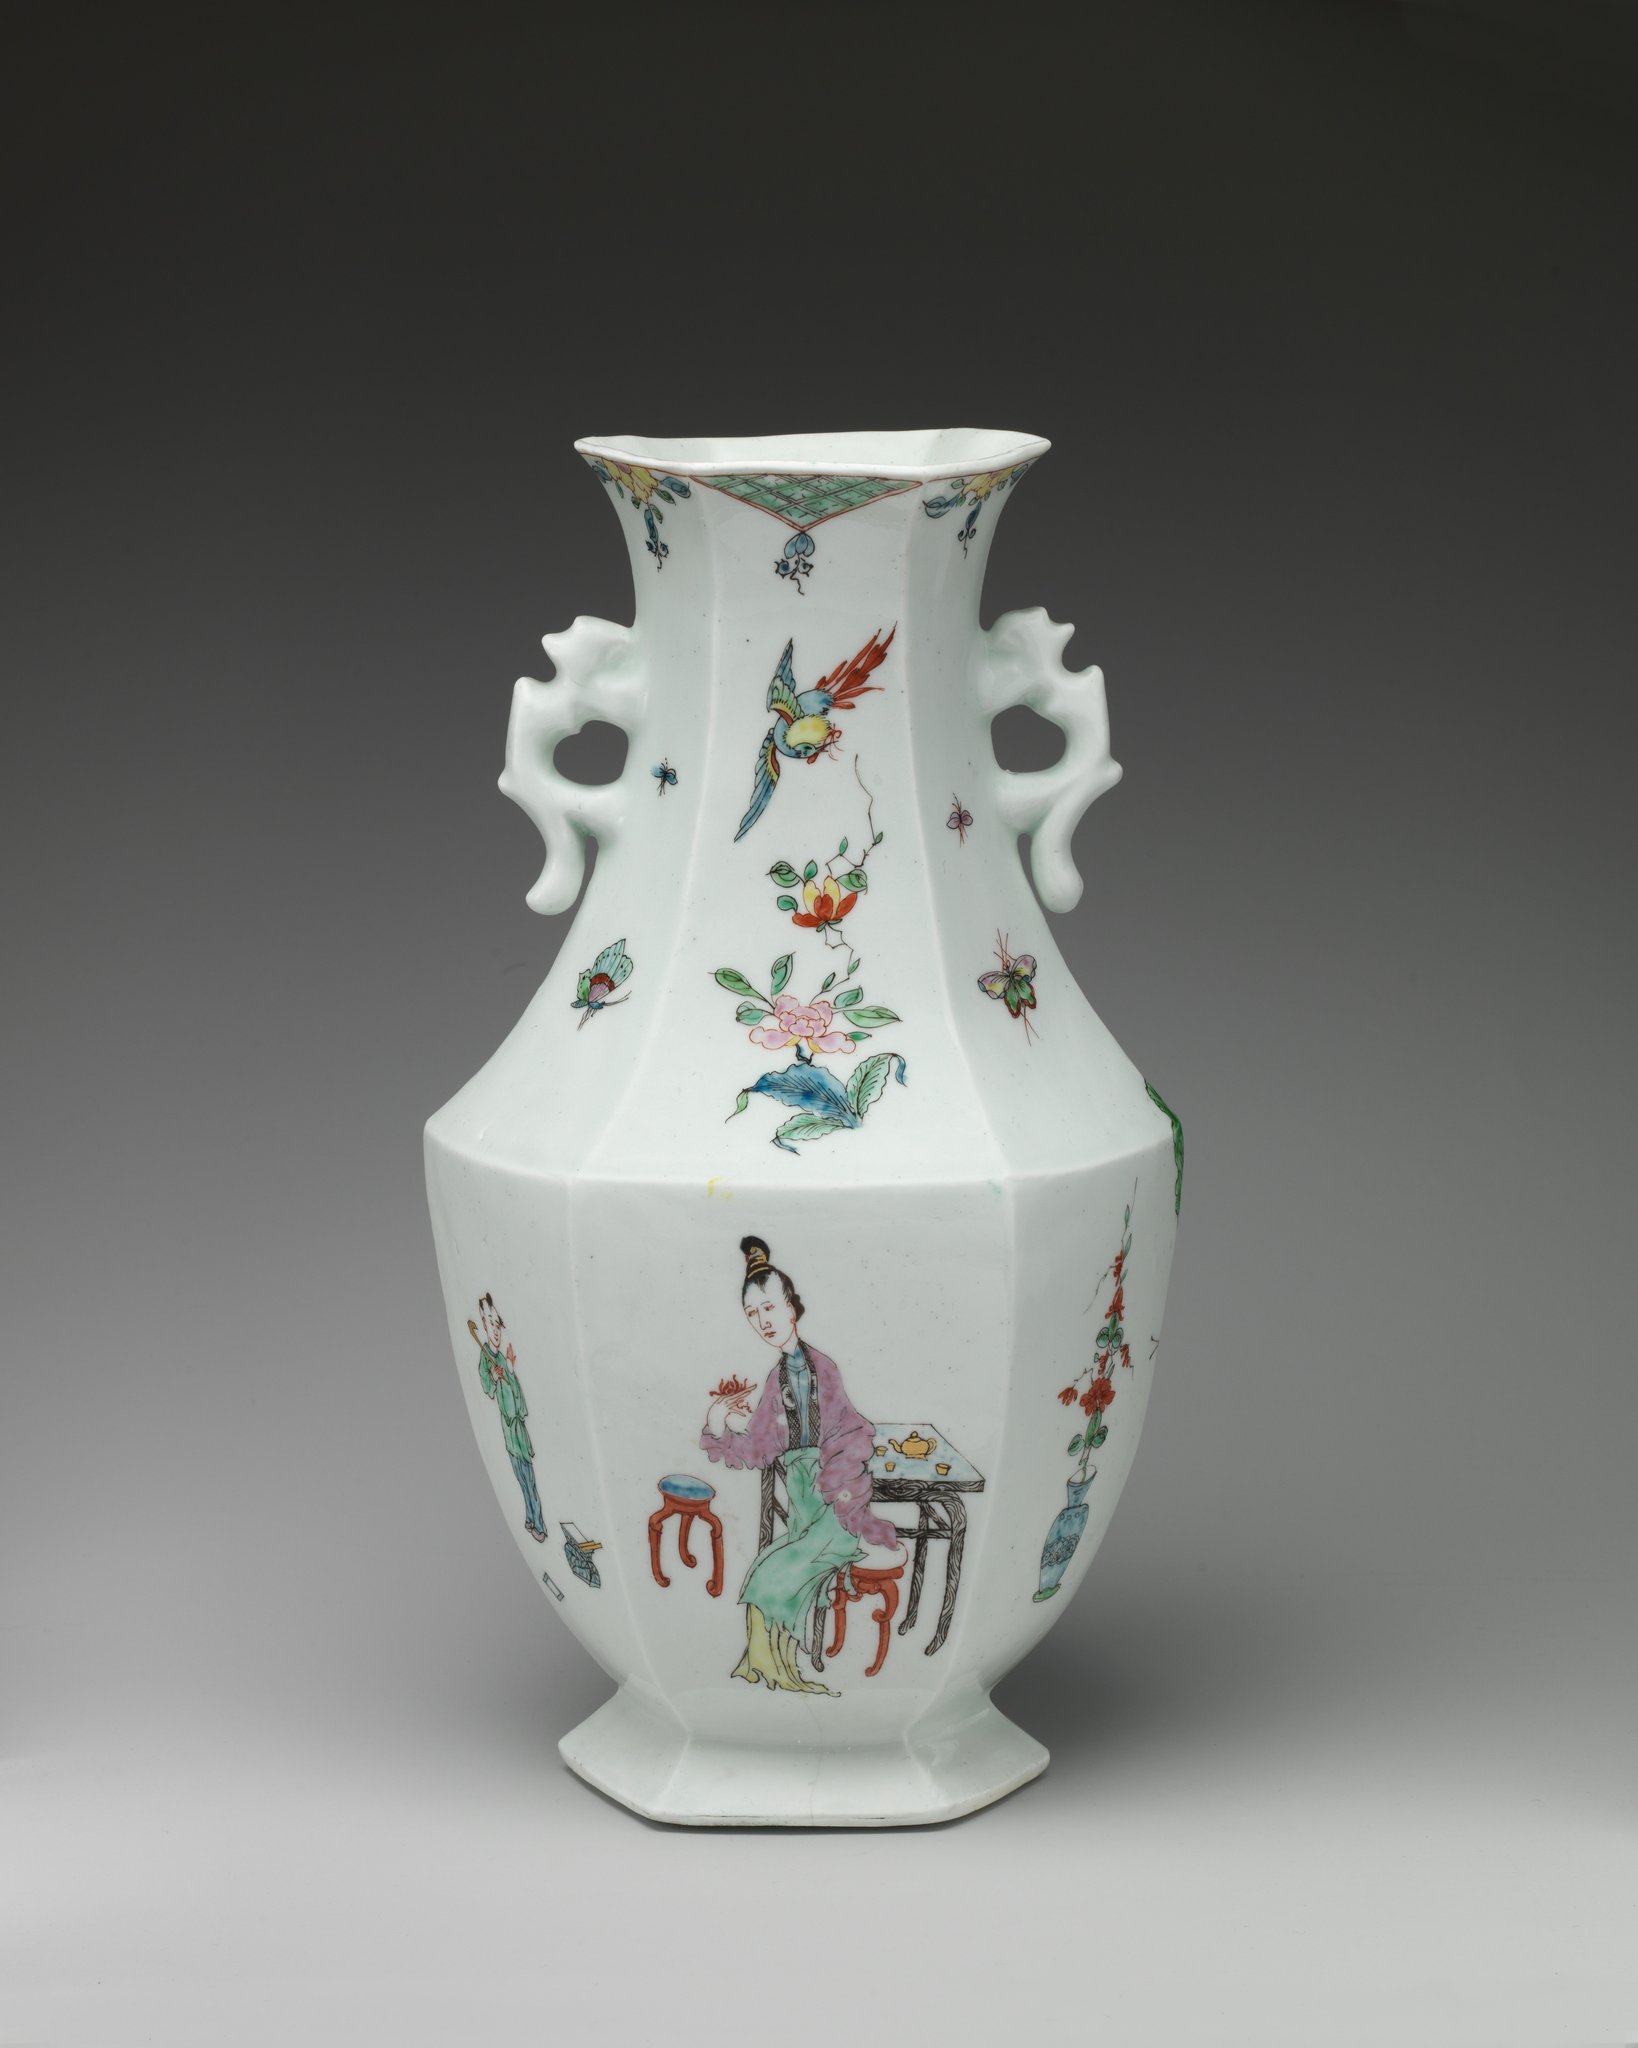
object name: vase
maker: worcester factory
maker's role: factory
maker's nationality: british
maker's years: 1751-2008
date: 1753-1754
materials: soft paste porcelain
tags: birds,women,flowers